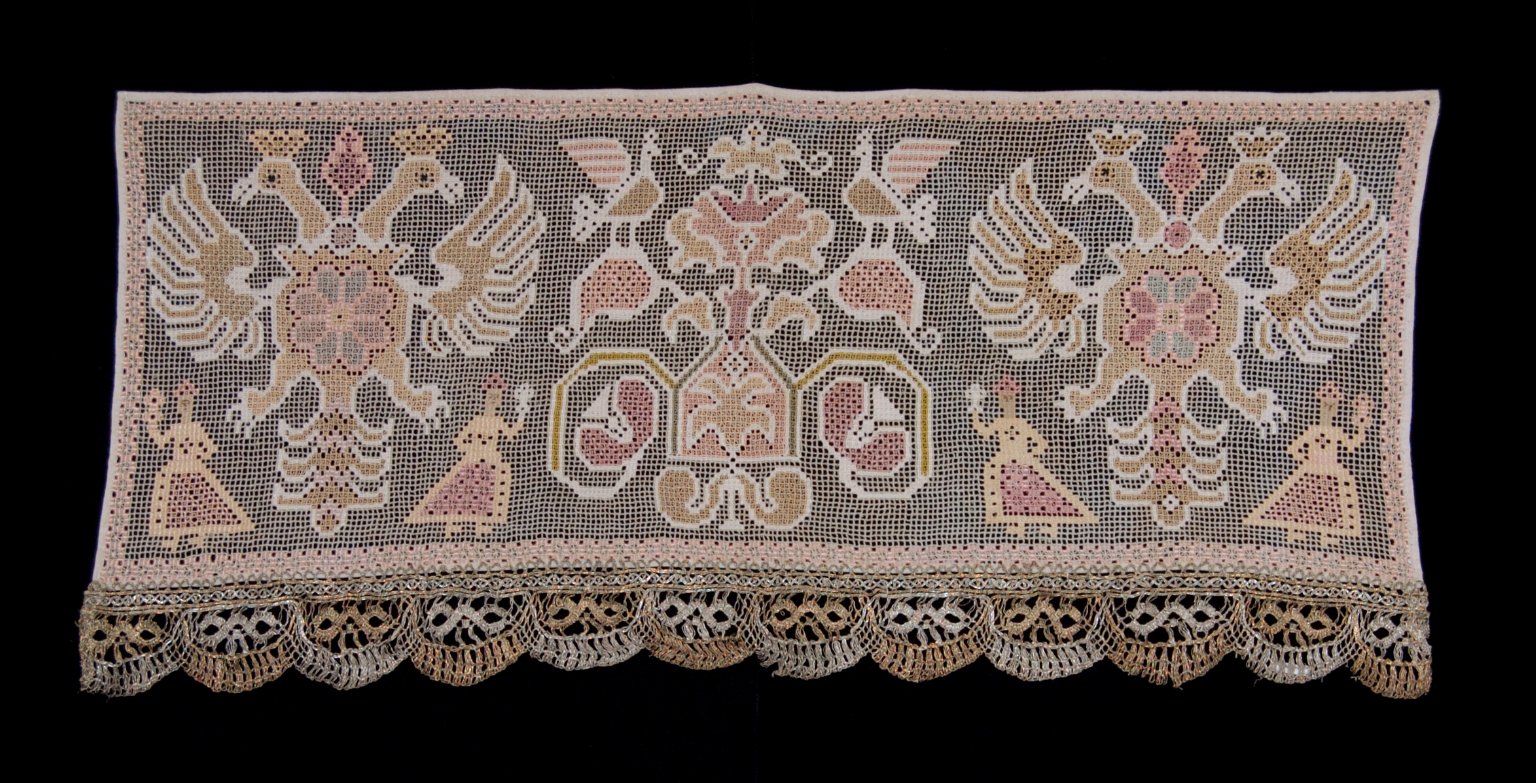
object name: border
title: Bed curtain border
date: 1800-1850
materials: linen, silk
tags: birds